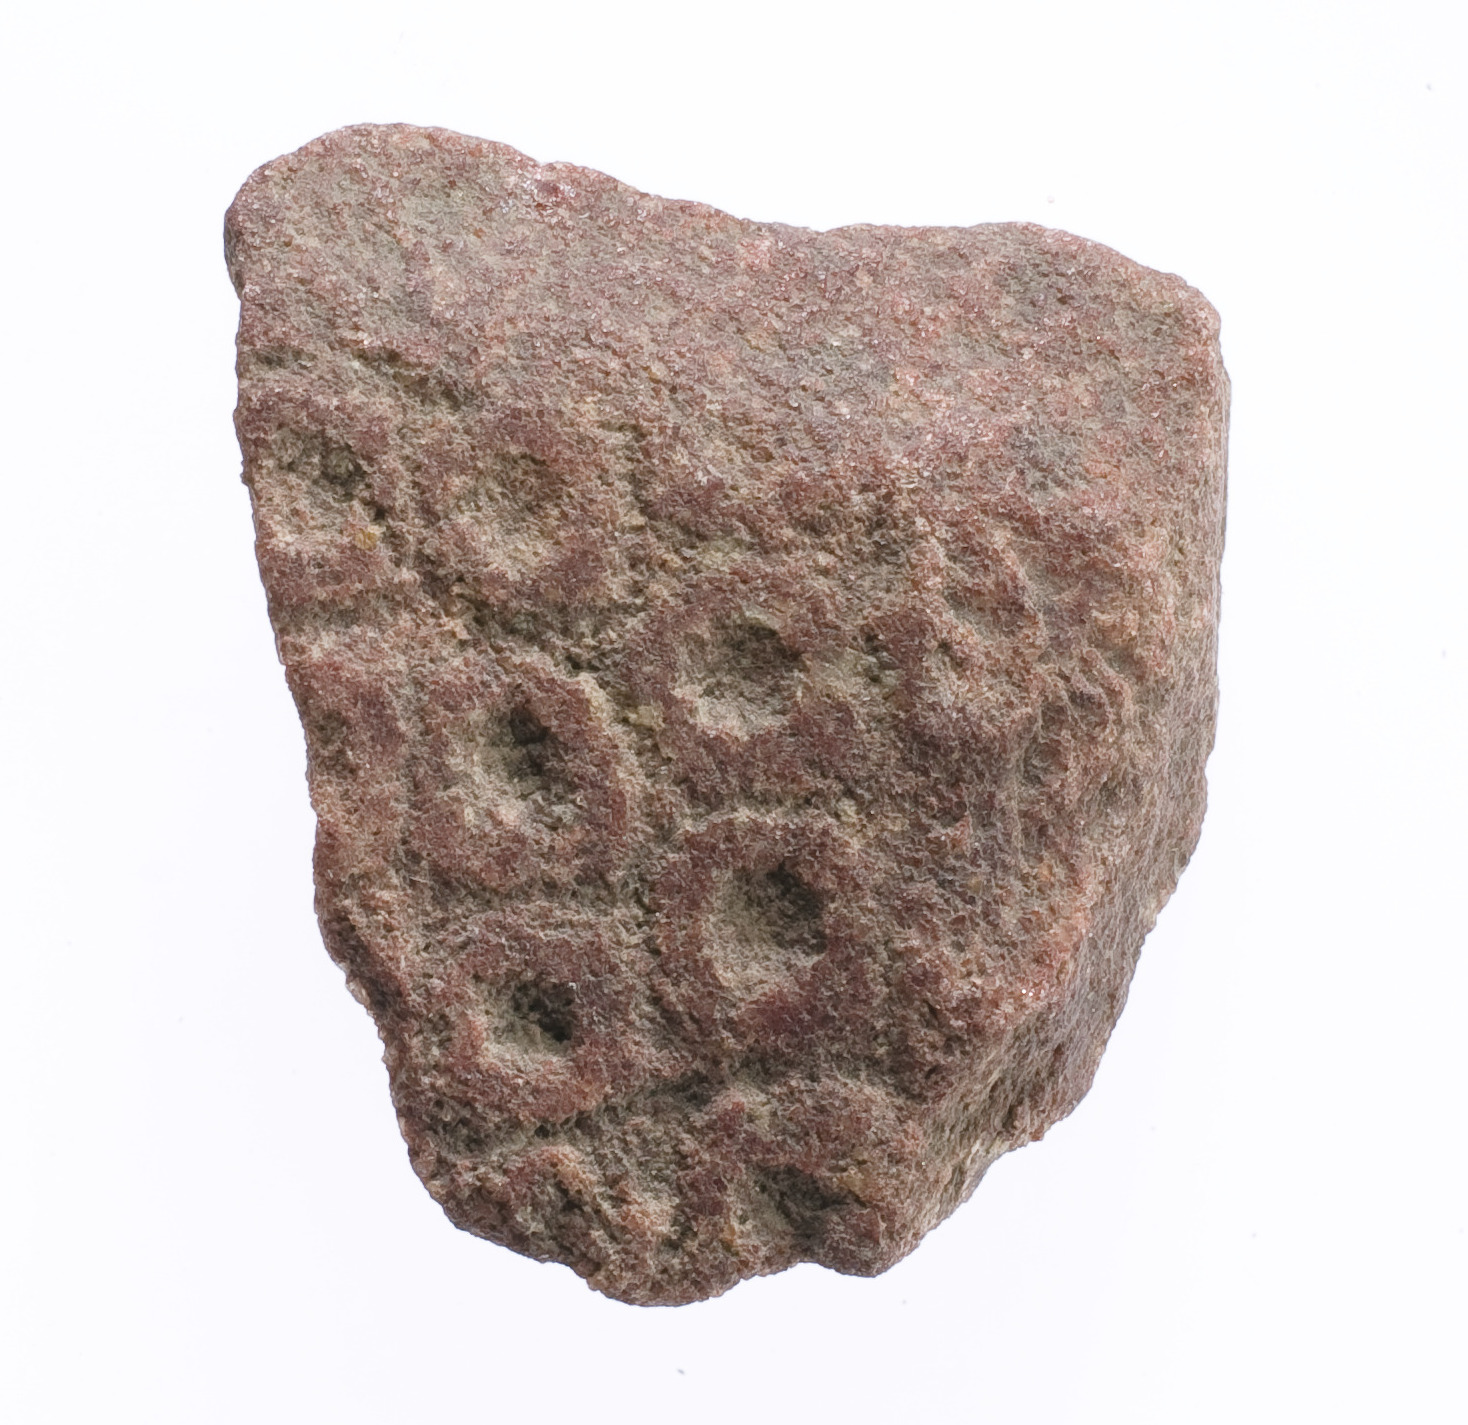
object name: crown with disc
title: Crown with discs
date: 1353-1336 BCE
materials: quartzite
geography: egypt